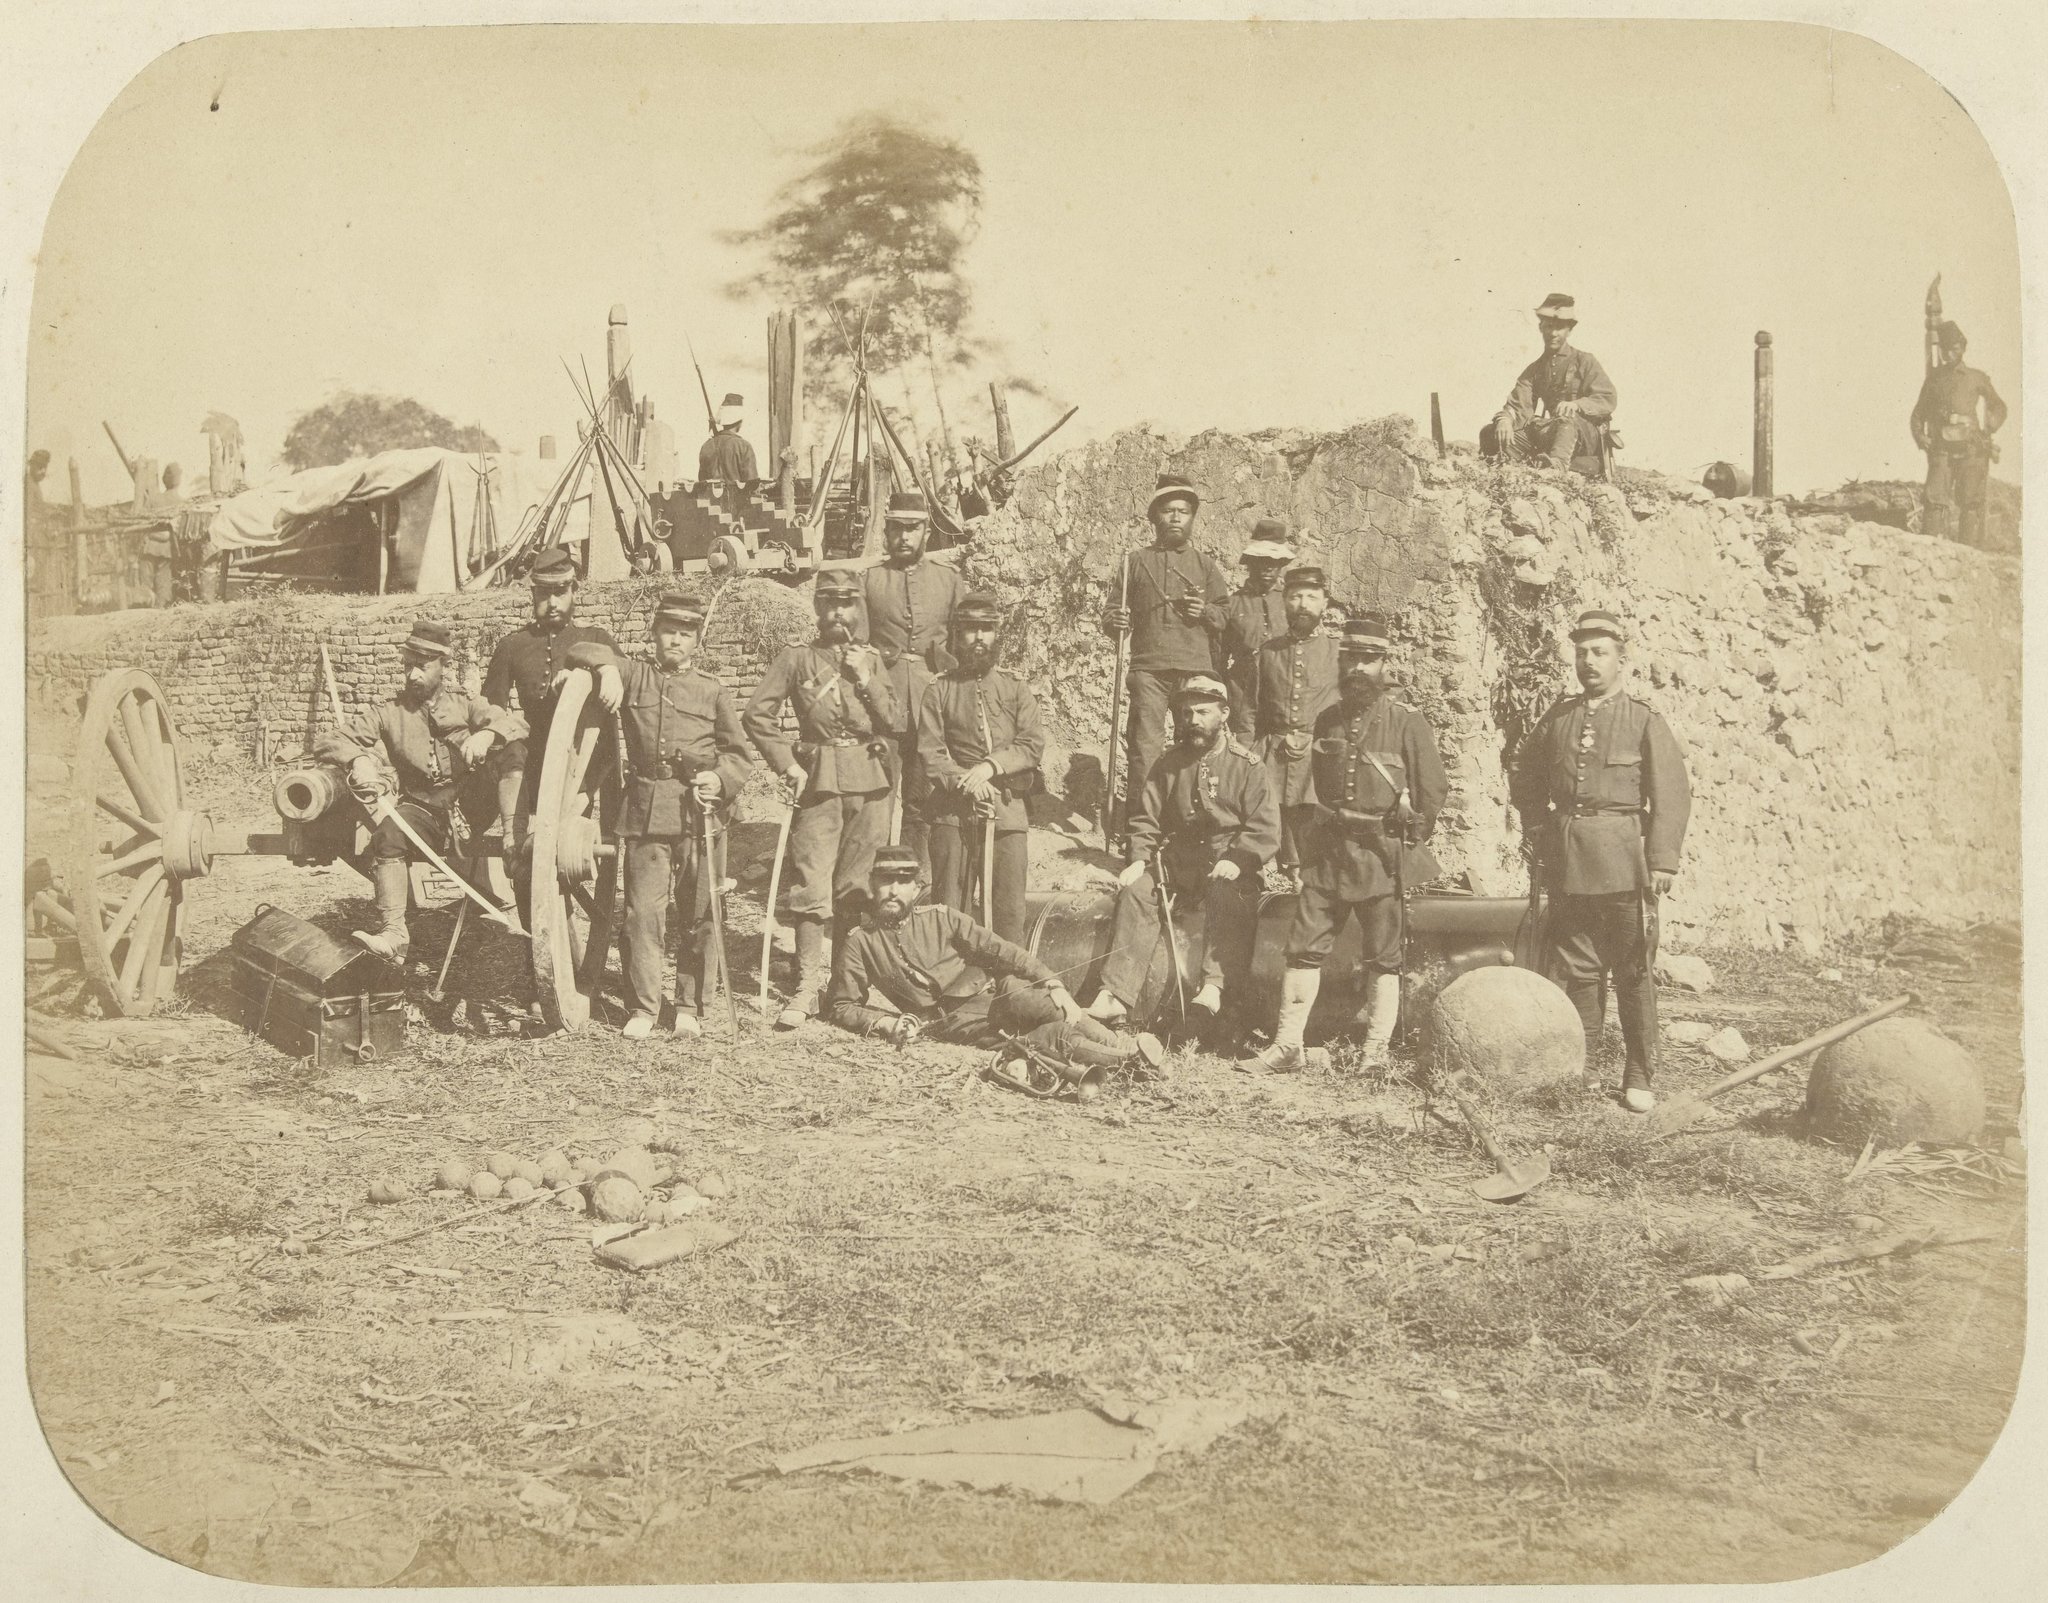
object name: photograph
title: Groepsportret van militairen bij de poort van de Kraton, nabij Batavia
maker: Anonymous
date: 1854-1890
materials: cardboard, paper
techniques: albumen print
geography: yogyakarta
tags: division of armed forces, anonymous historical persons portrayed in a group, in a group-portrait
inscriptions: inscription: ‘No. 29. Groep officieren van het linkerhalf 3e Bat. aan de poort van den Kraton./ Groupe d'Officiers du 3ième Bataillon (moitié gauche) à la porte du Kraton. Group of Officers belonging to the 3rd Bataillon (left half) at the gate of the Kraton./ H.M. van Dorp & Co., Batavia.’